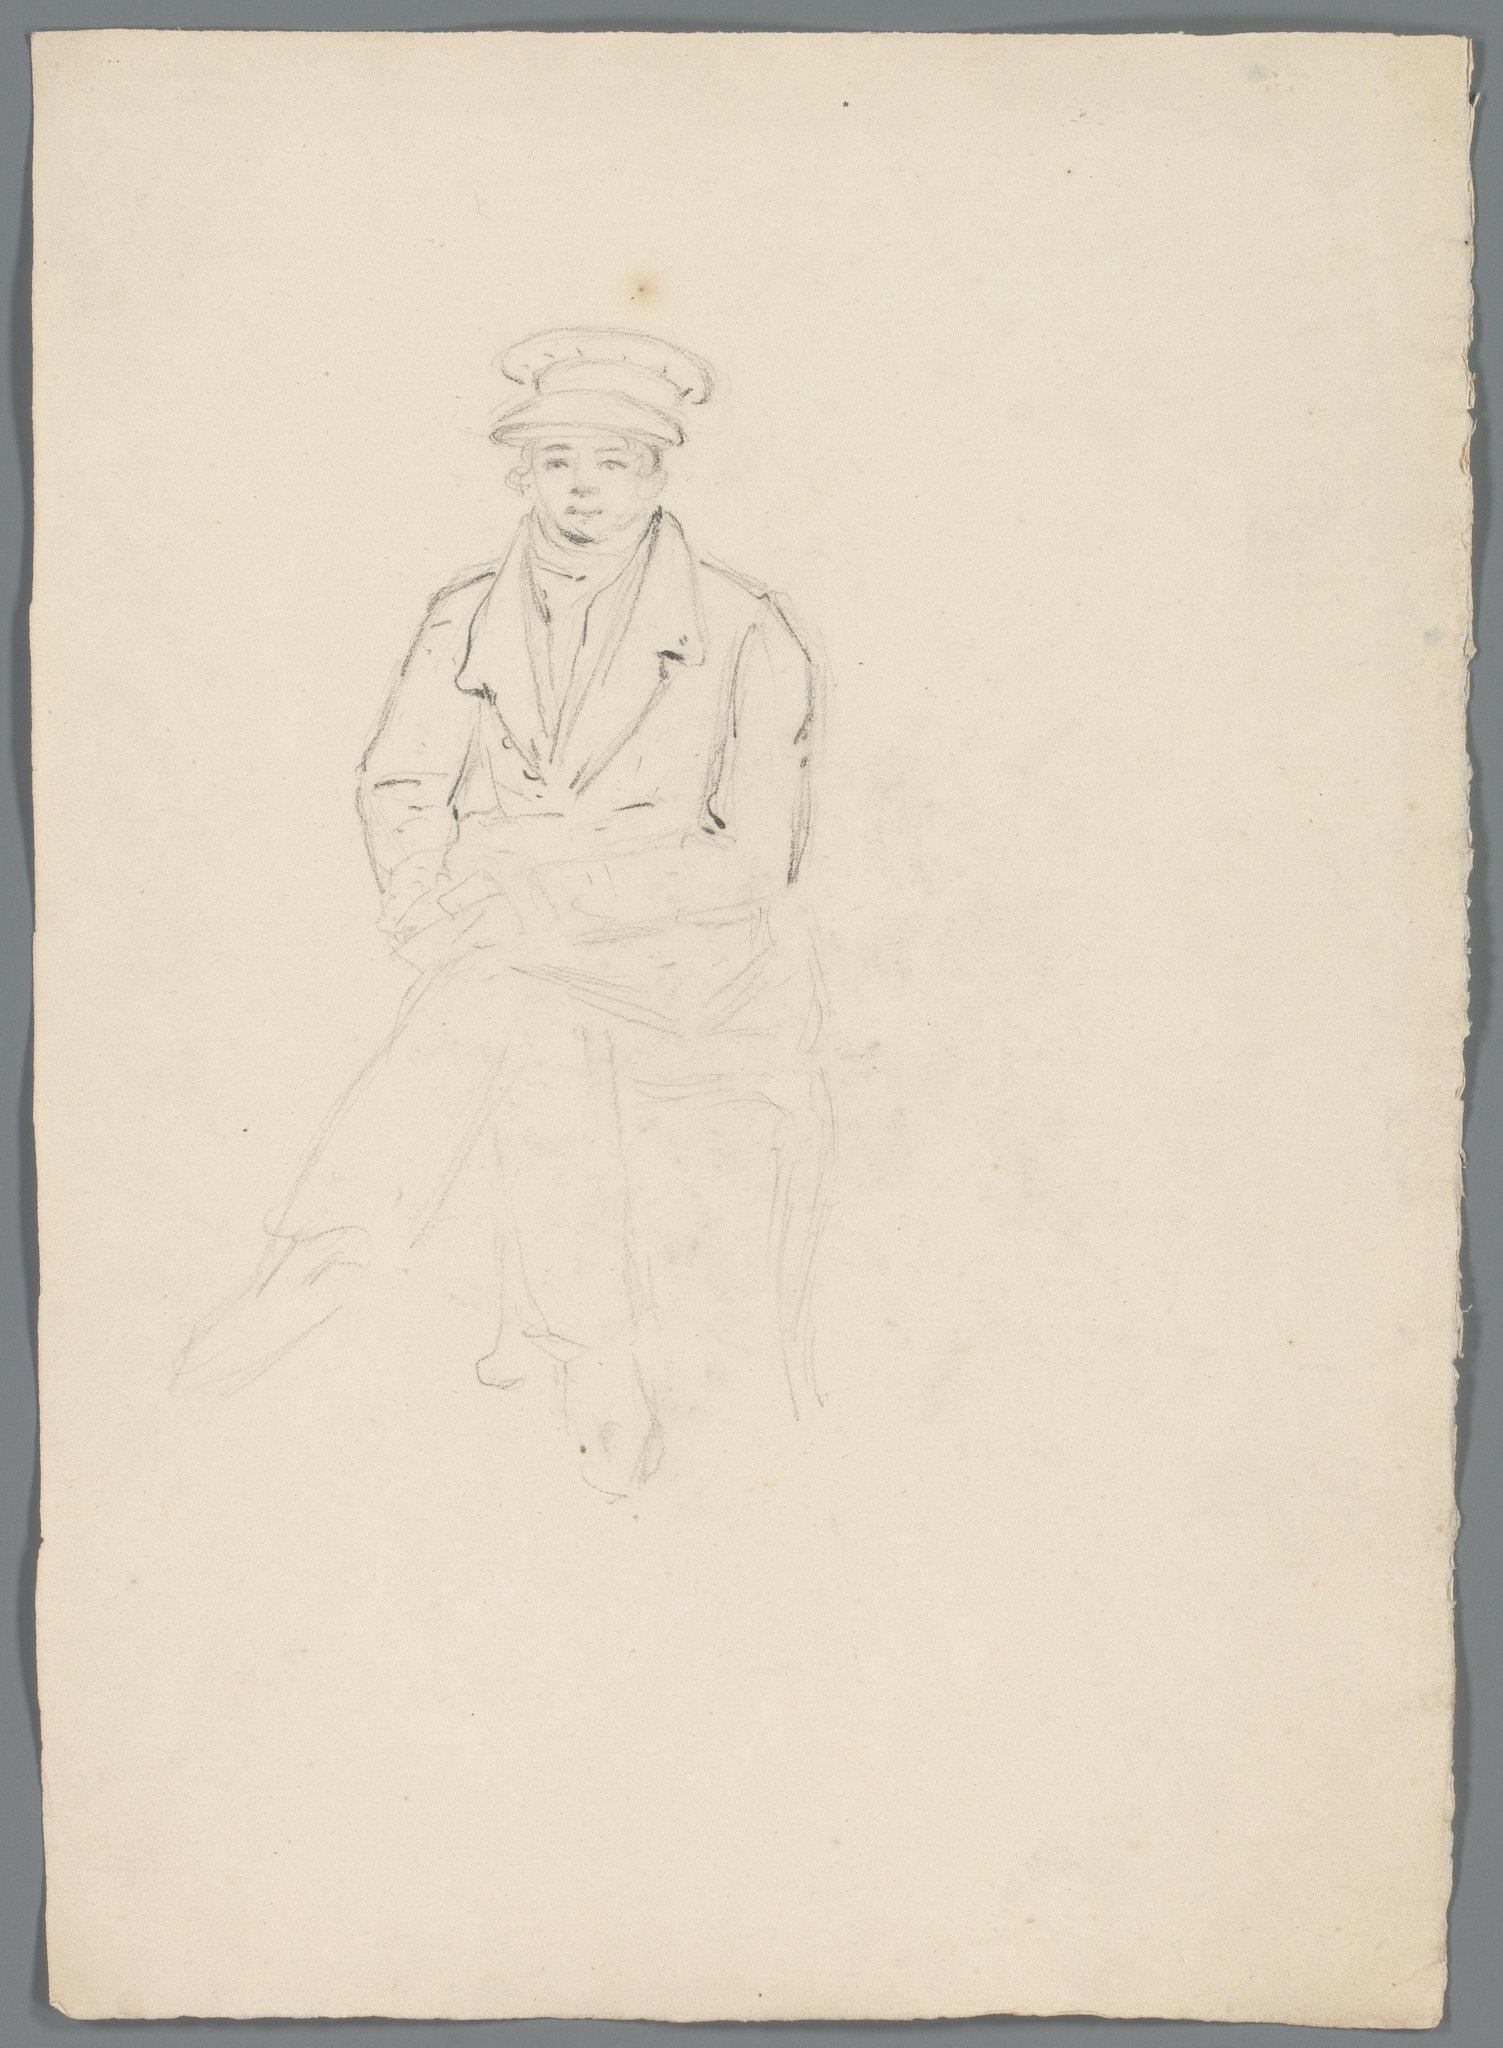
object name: drawing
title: Figuurstudie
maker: Anonymous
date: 1820-1830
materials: chalk, paper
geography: the hague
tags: sitting figure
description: Tekeningen waarschijnlijk ontstaan bij het Haagse kunstgenootschap ‘Tot Nut der Tekenkunst’, waar twee keer per week tekenavonden werden georganiseerd met geklede modellen.